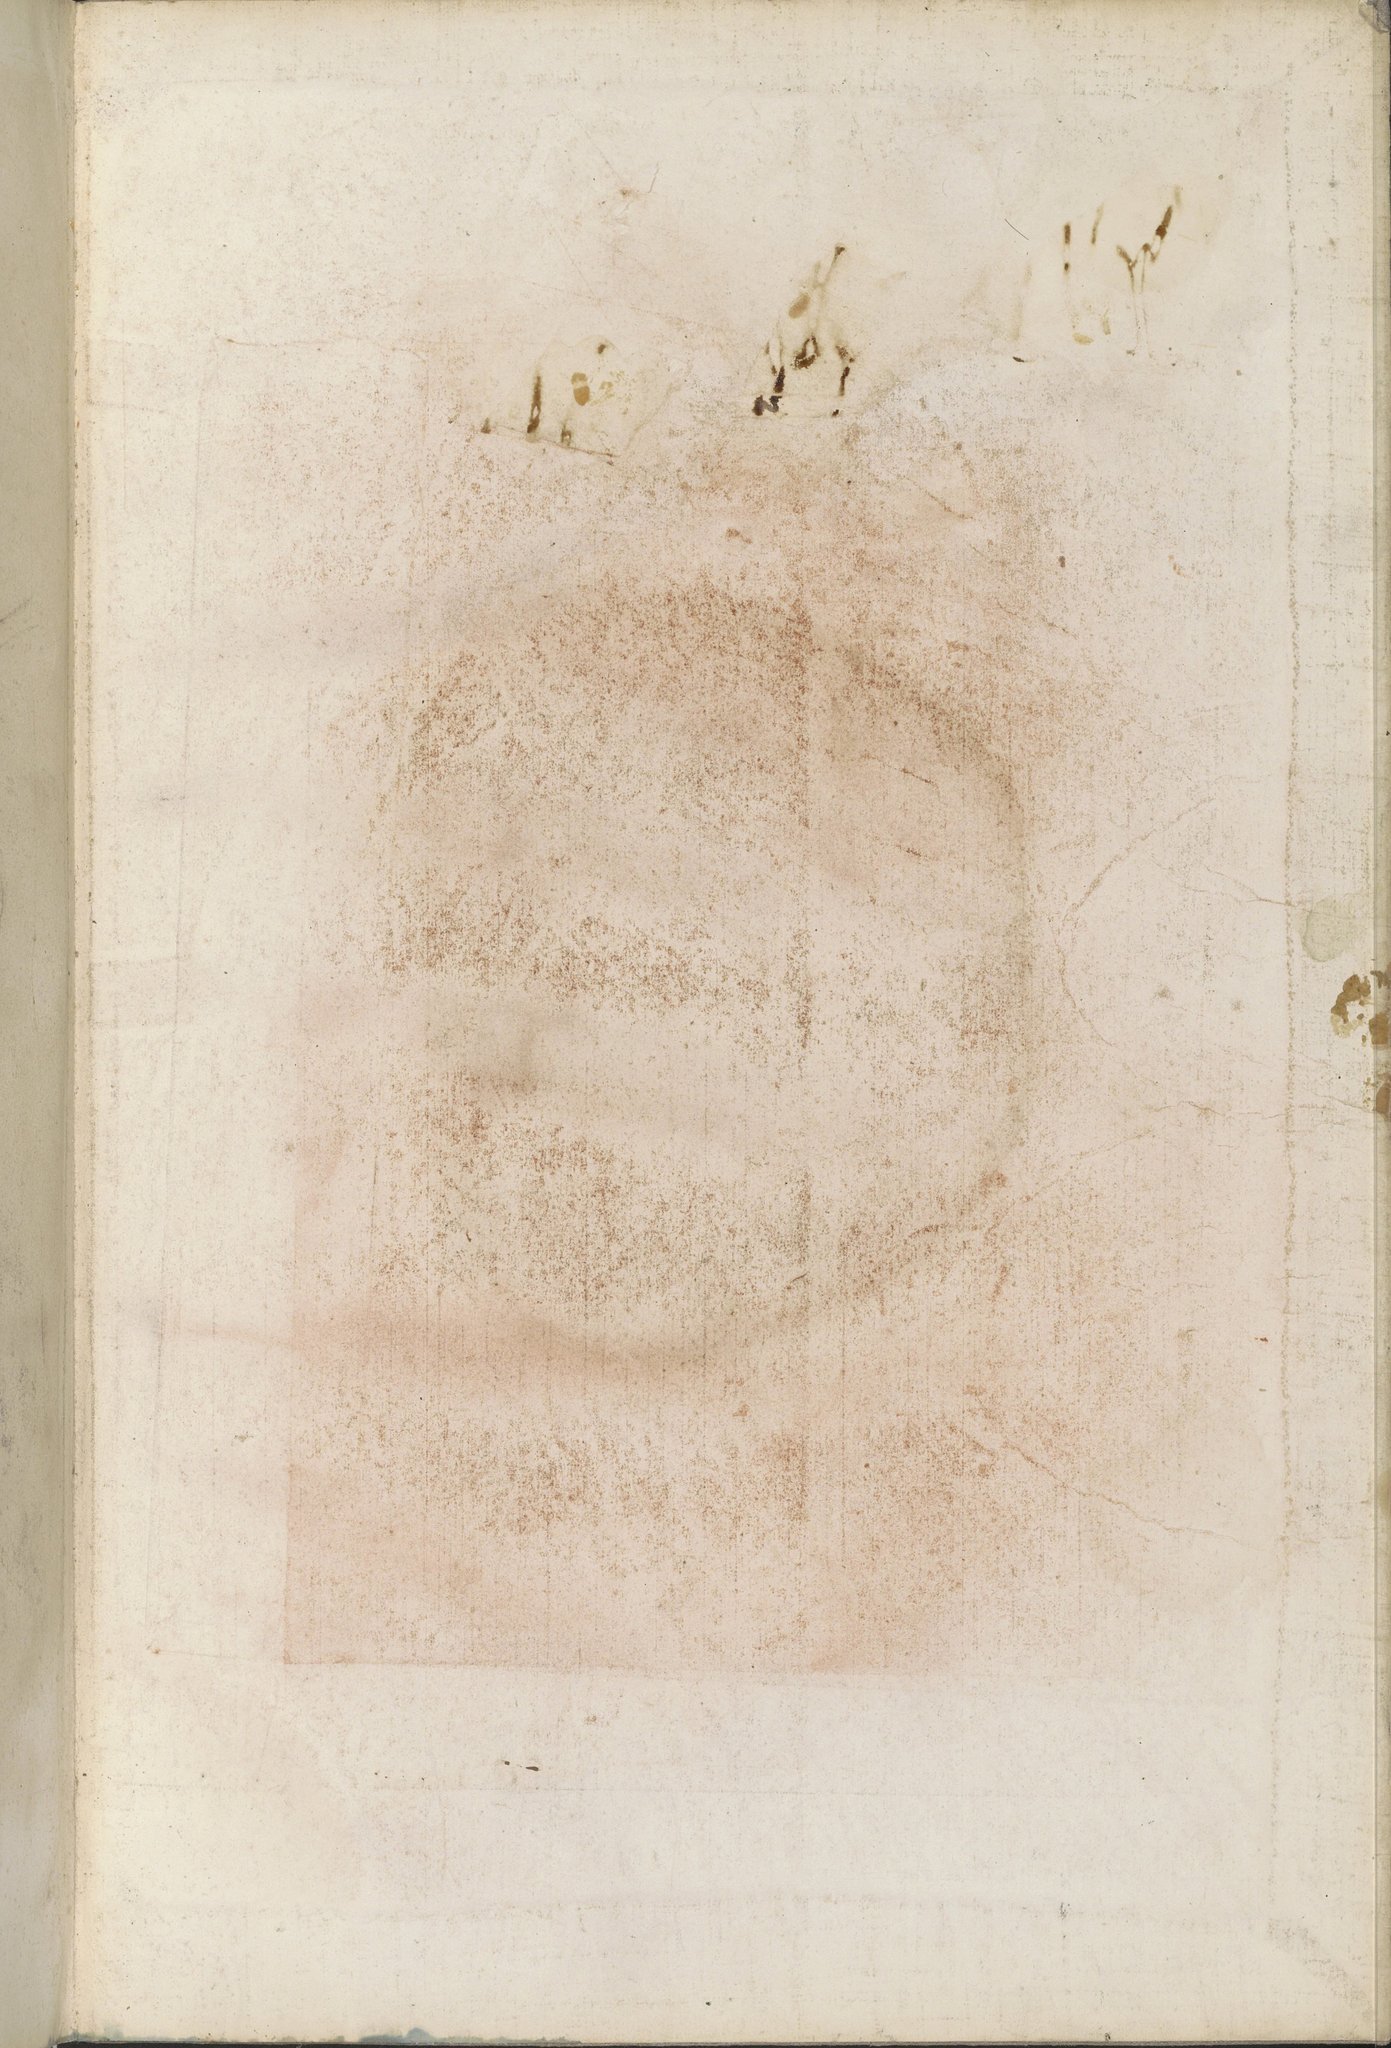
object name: sketchbook leaf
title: Studie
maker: willem witsen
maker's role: draughtsman, painter, print maker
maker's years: 1860-1923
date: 1884-1887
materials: chalk, paper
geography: ewijkshoeve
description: Schutblad B, achterste schutblad, uit een schetsboek met 38 bladen.